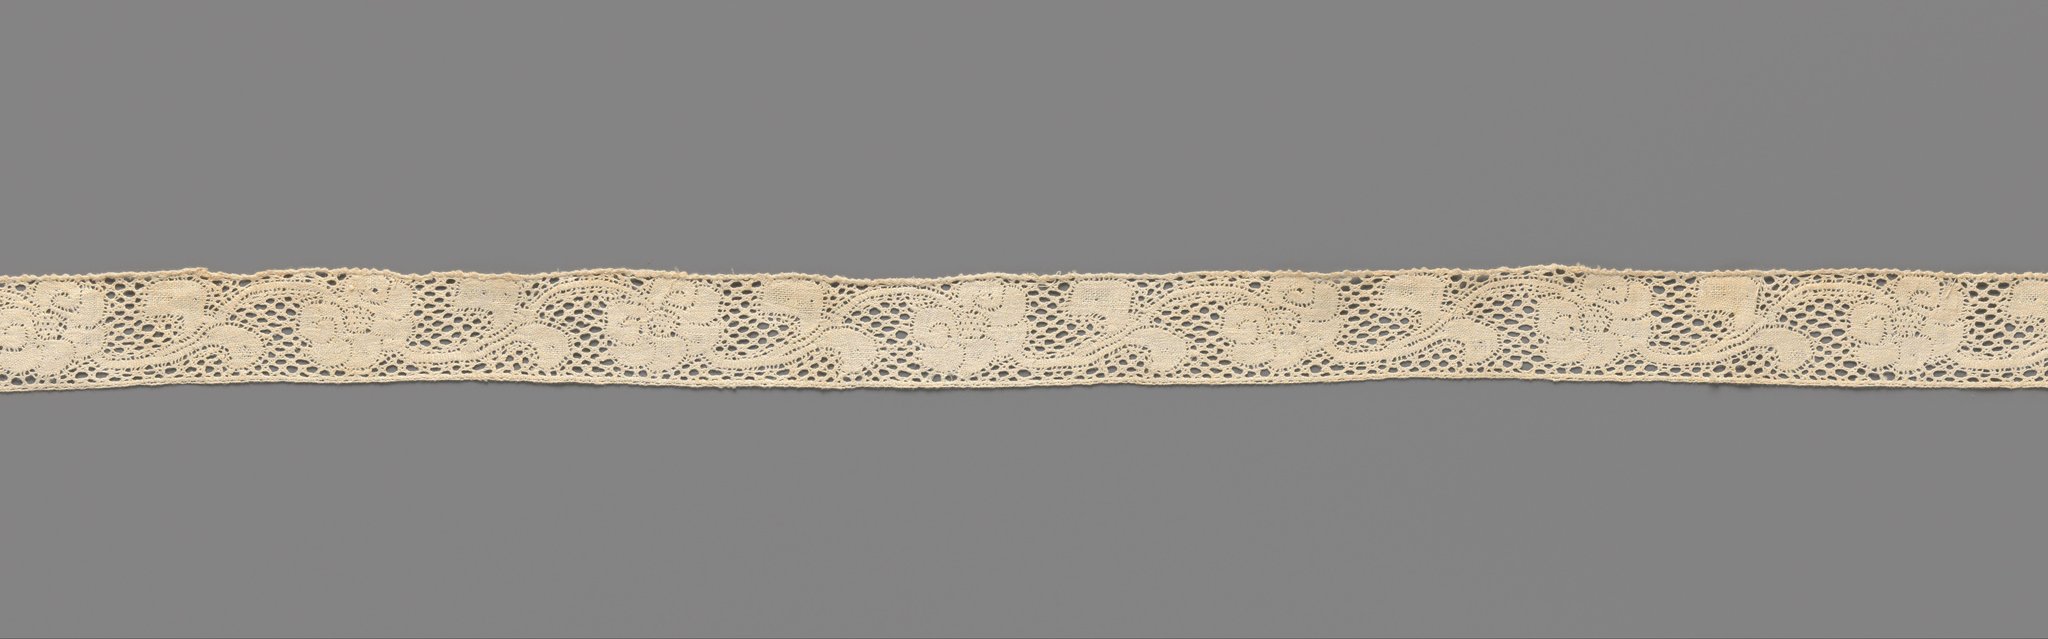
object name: entre deux, tussenzetsel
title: Strook kloskant met aaneengeschakelde golvende bloemstengels met één bloem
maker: Anonymous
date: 1650-1699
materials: linen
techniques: lace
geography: southern netherlands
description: Strook naturelkleurige kloskant: oudvlaamse kant. Het zich herhalende patroon bestaat uit aaneengeschakelde golvende bloemstengels, met steeds één bloem en aan weerszijden van de stengel één blad. De bloem bestaat uit zes lobben rond een cirkelvormig bloemhart. De motieven zijn gemaakt in linnenslag met opengewerkte randjes en met uitsparingen in het bloemhart. De motieven zijn met elkaar verbonden door een traliegrond: een vijfgaatjesgrond. De boven- en onderzijde van de strook zijn recht afgewerkt.